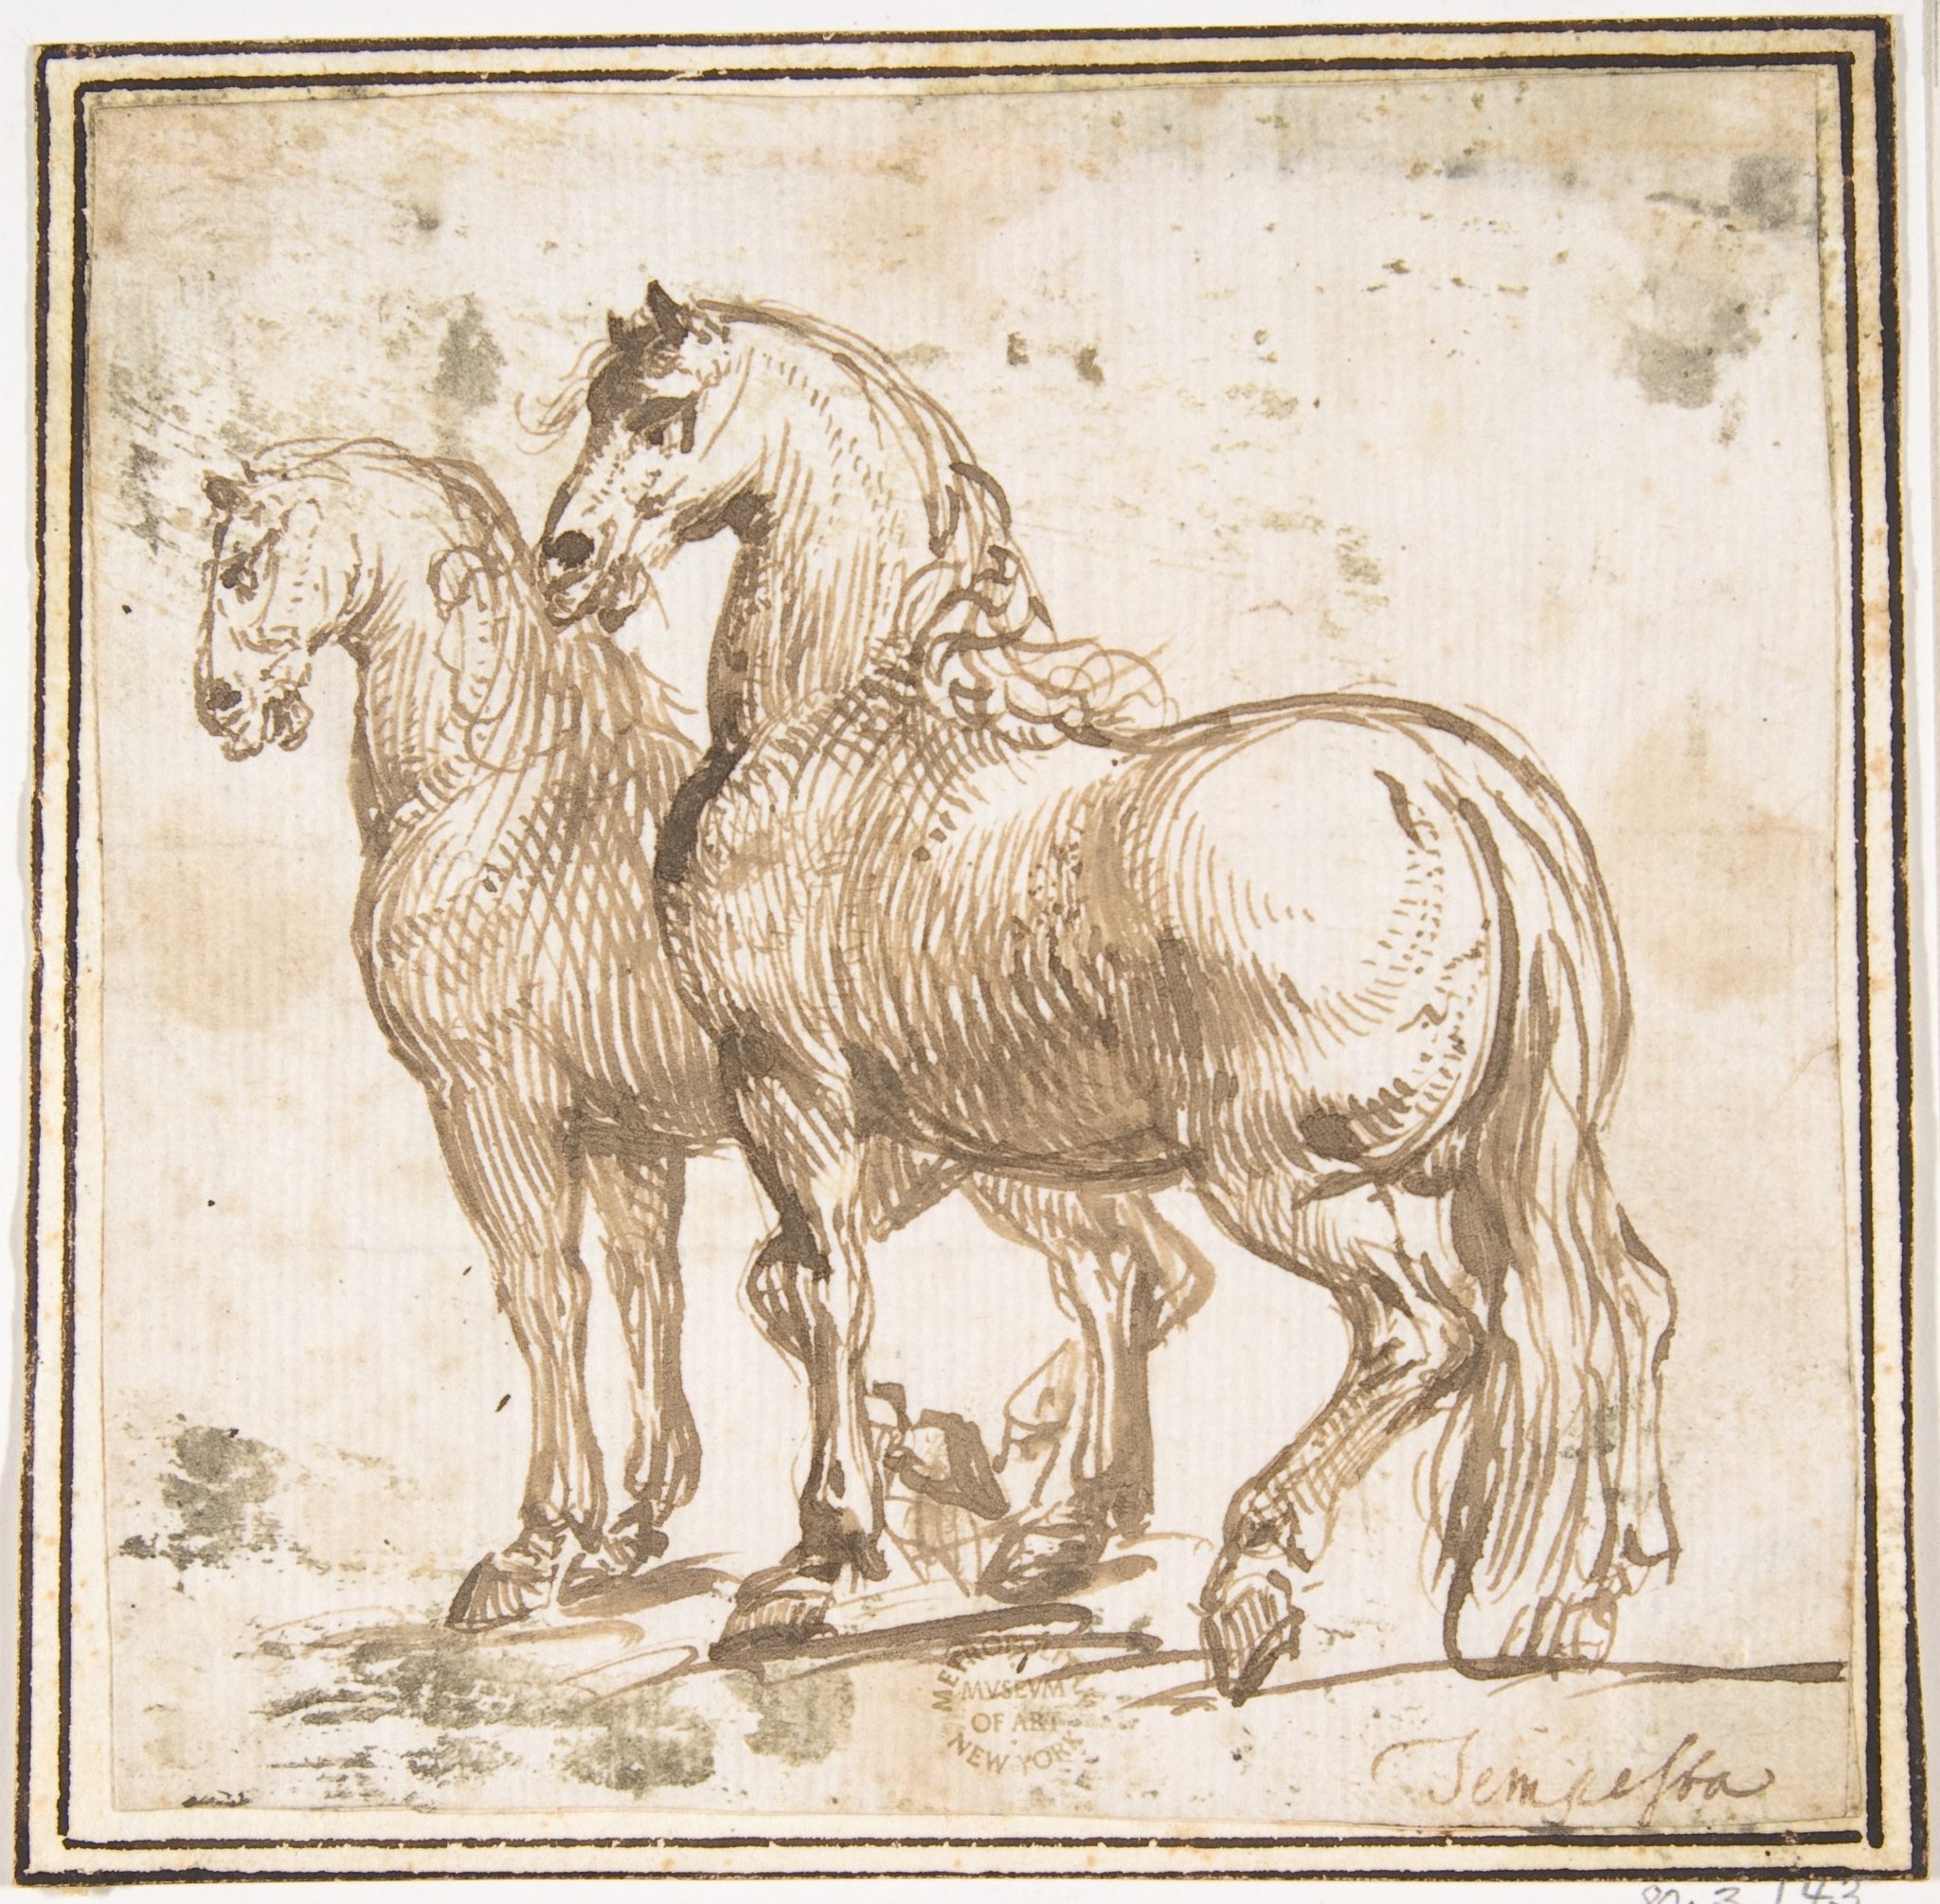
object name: drawing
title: Two Horses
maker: francesco allegrini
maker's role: artist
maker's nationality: italian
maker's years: 1615-1679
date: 1624-1663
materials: ink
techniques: pen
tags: horses